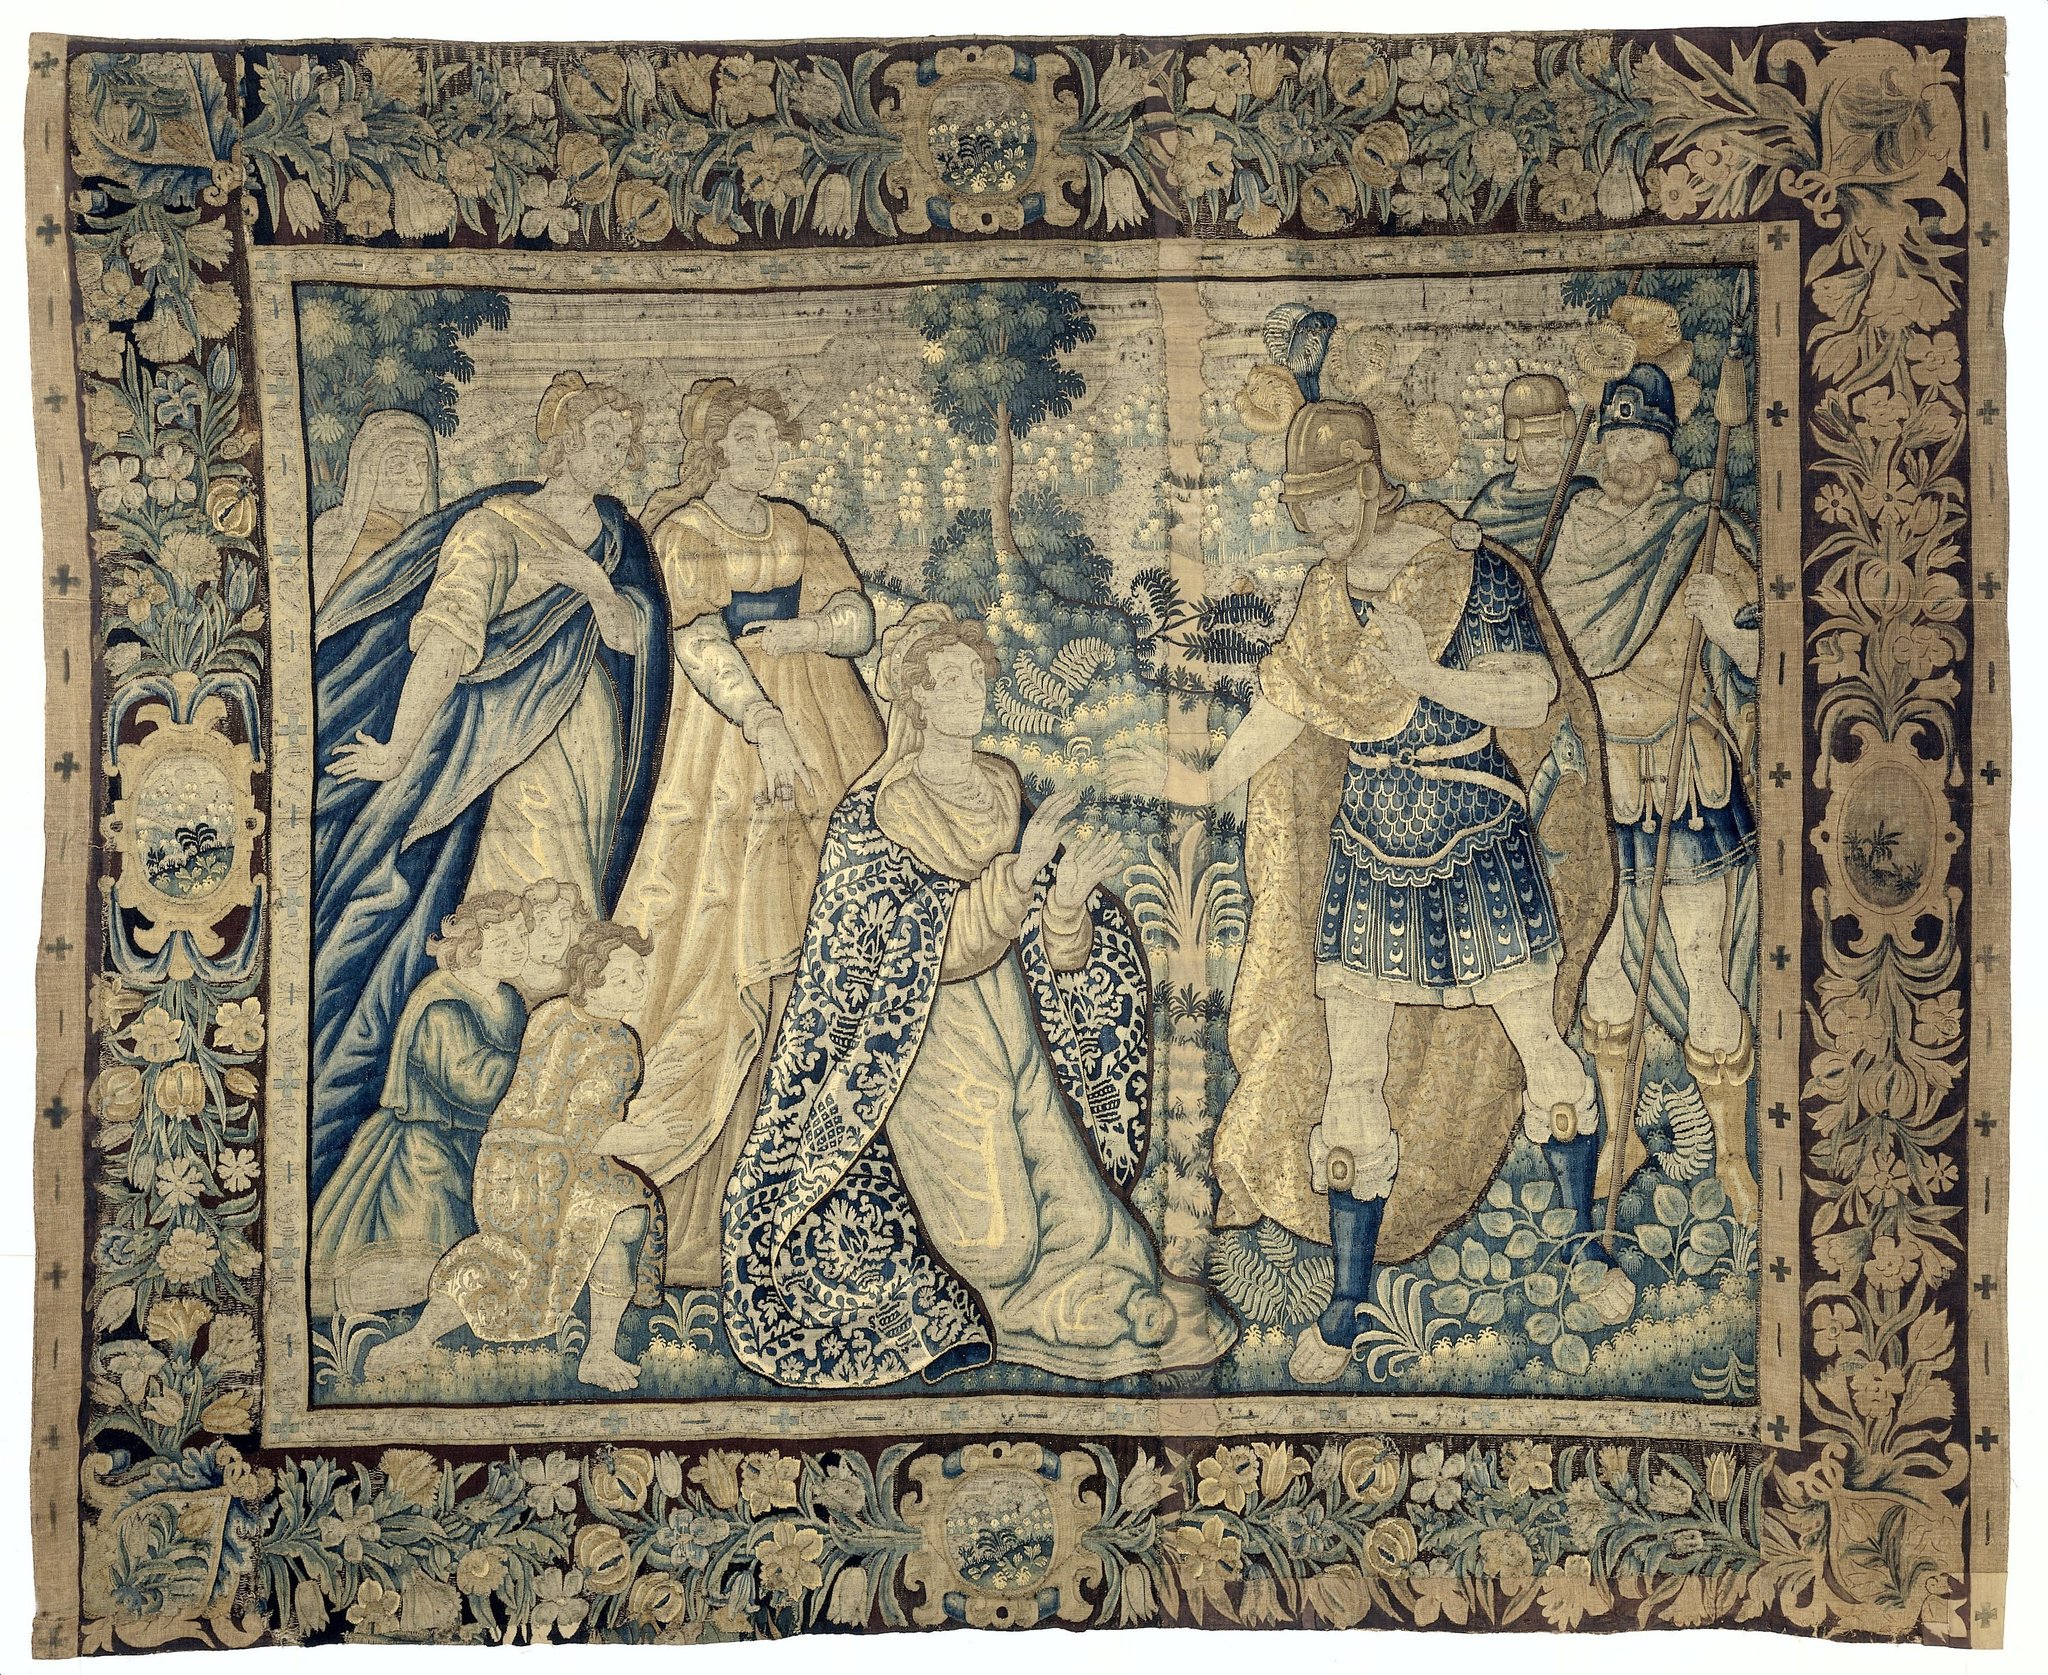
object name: tapestry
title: De familie van Darius voor Alexander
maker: Anonymous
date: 1625-1650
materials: silk, wool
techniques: tapestry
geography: southern netherlands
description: Wandtapijt met de familie van Darius voor Alexander, uit een serie met de geschiedenis van Alexander de Grote.